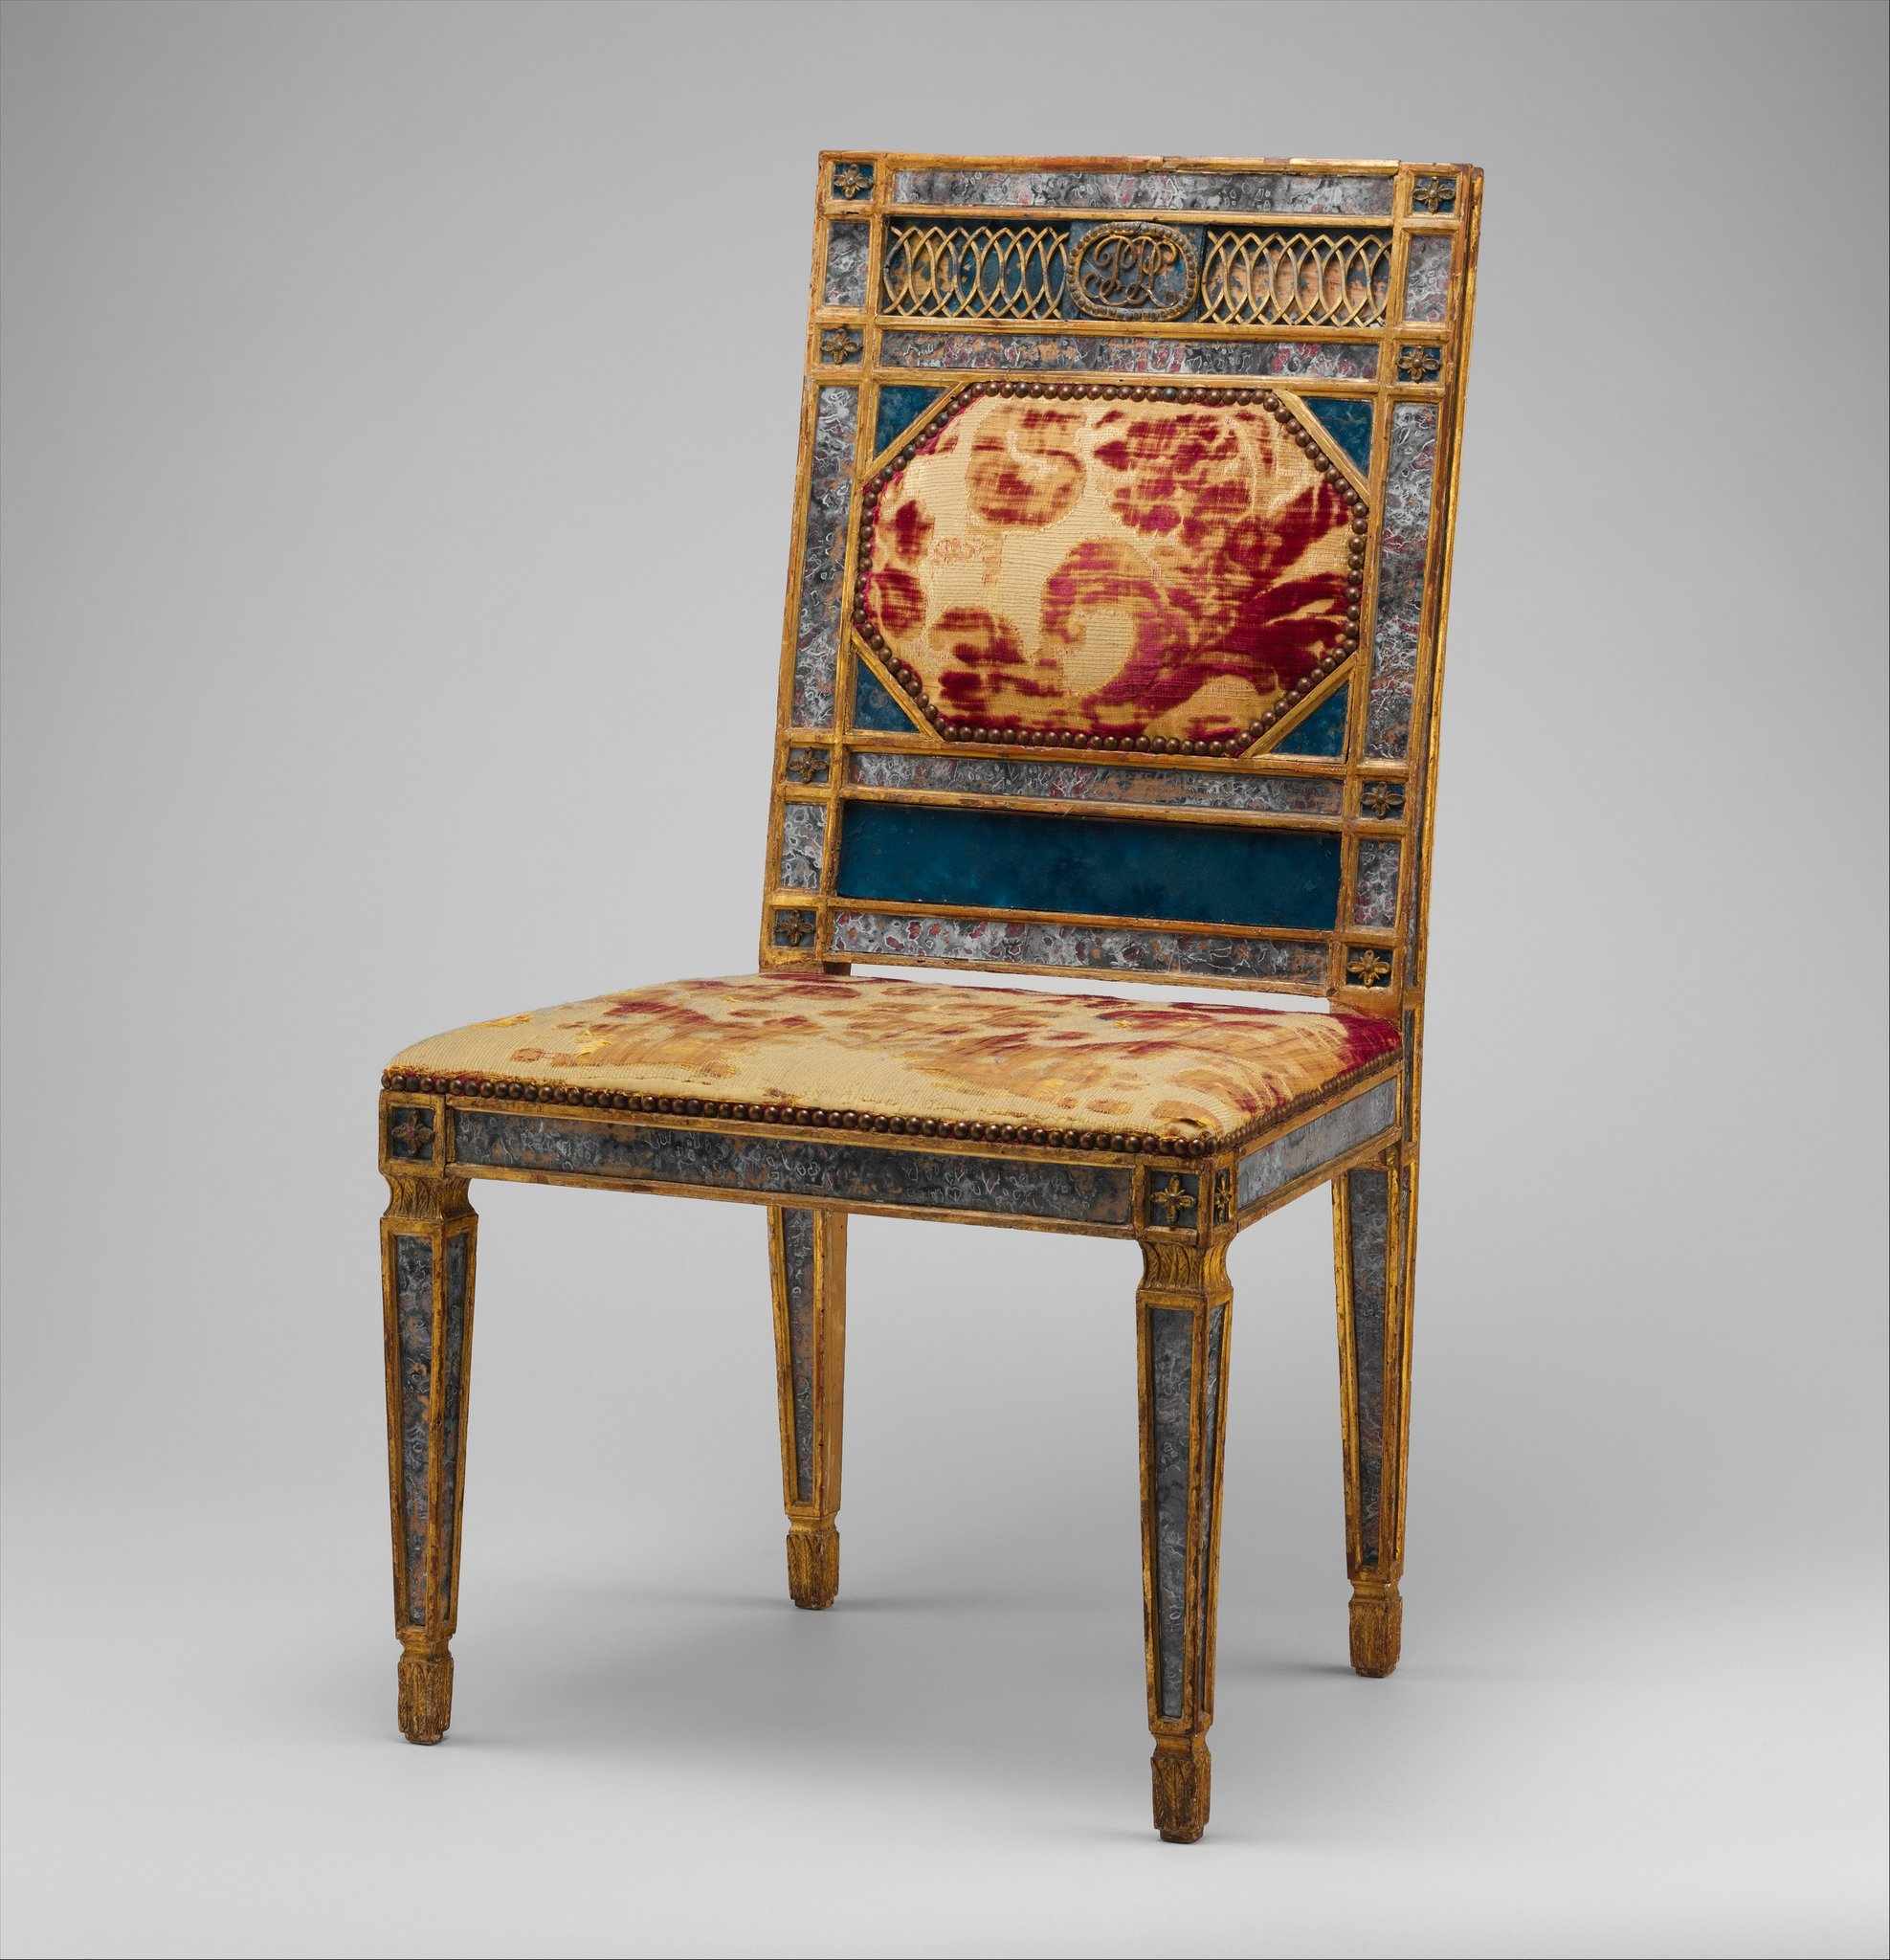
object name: side chair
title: Side chair (part of a set)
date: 1790-1800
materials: glass, silk, velvet, wood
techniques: carving, cutting, gilding, painting, voiding